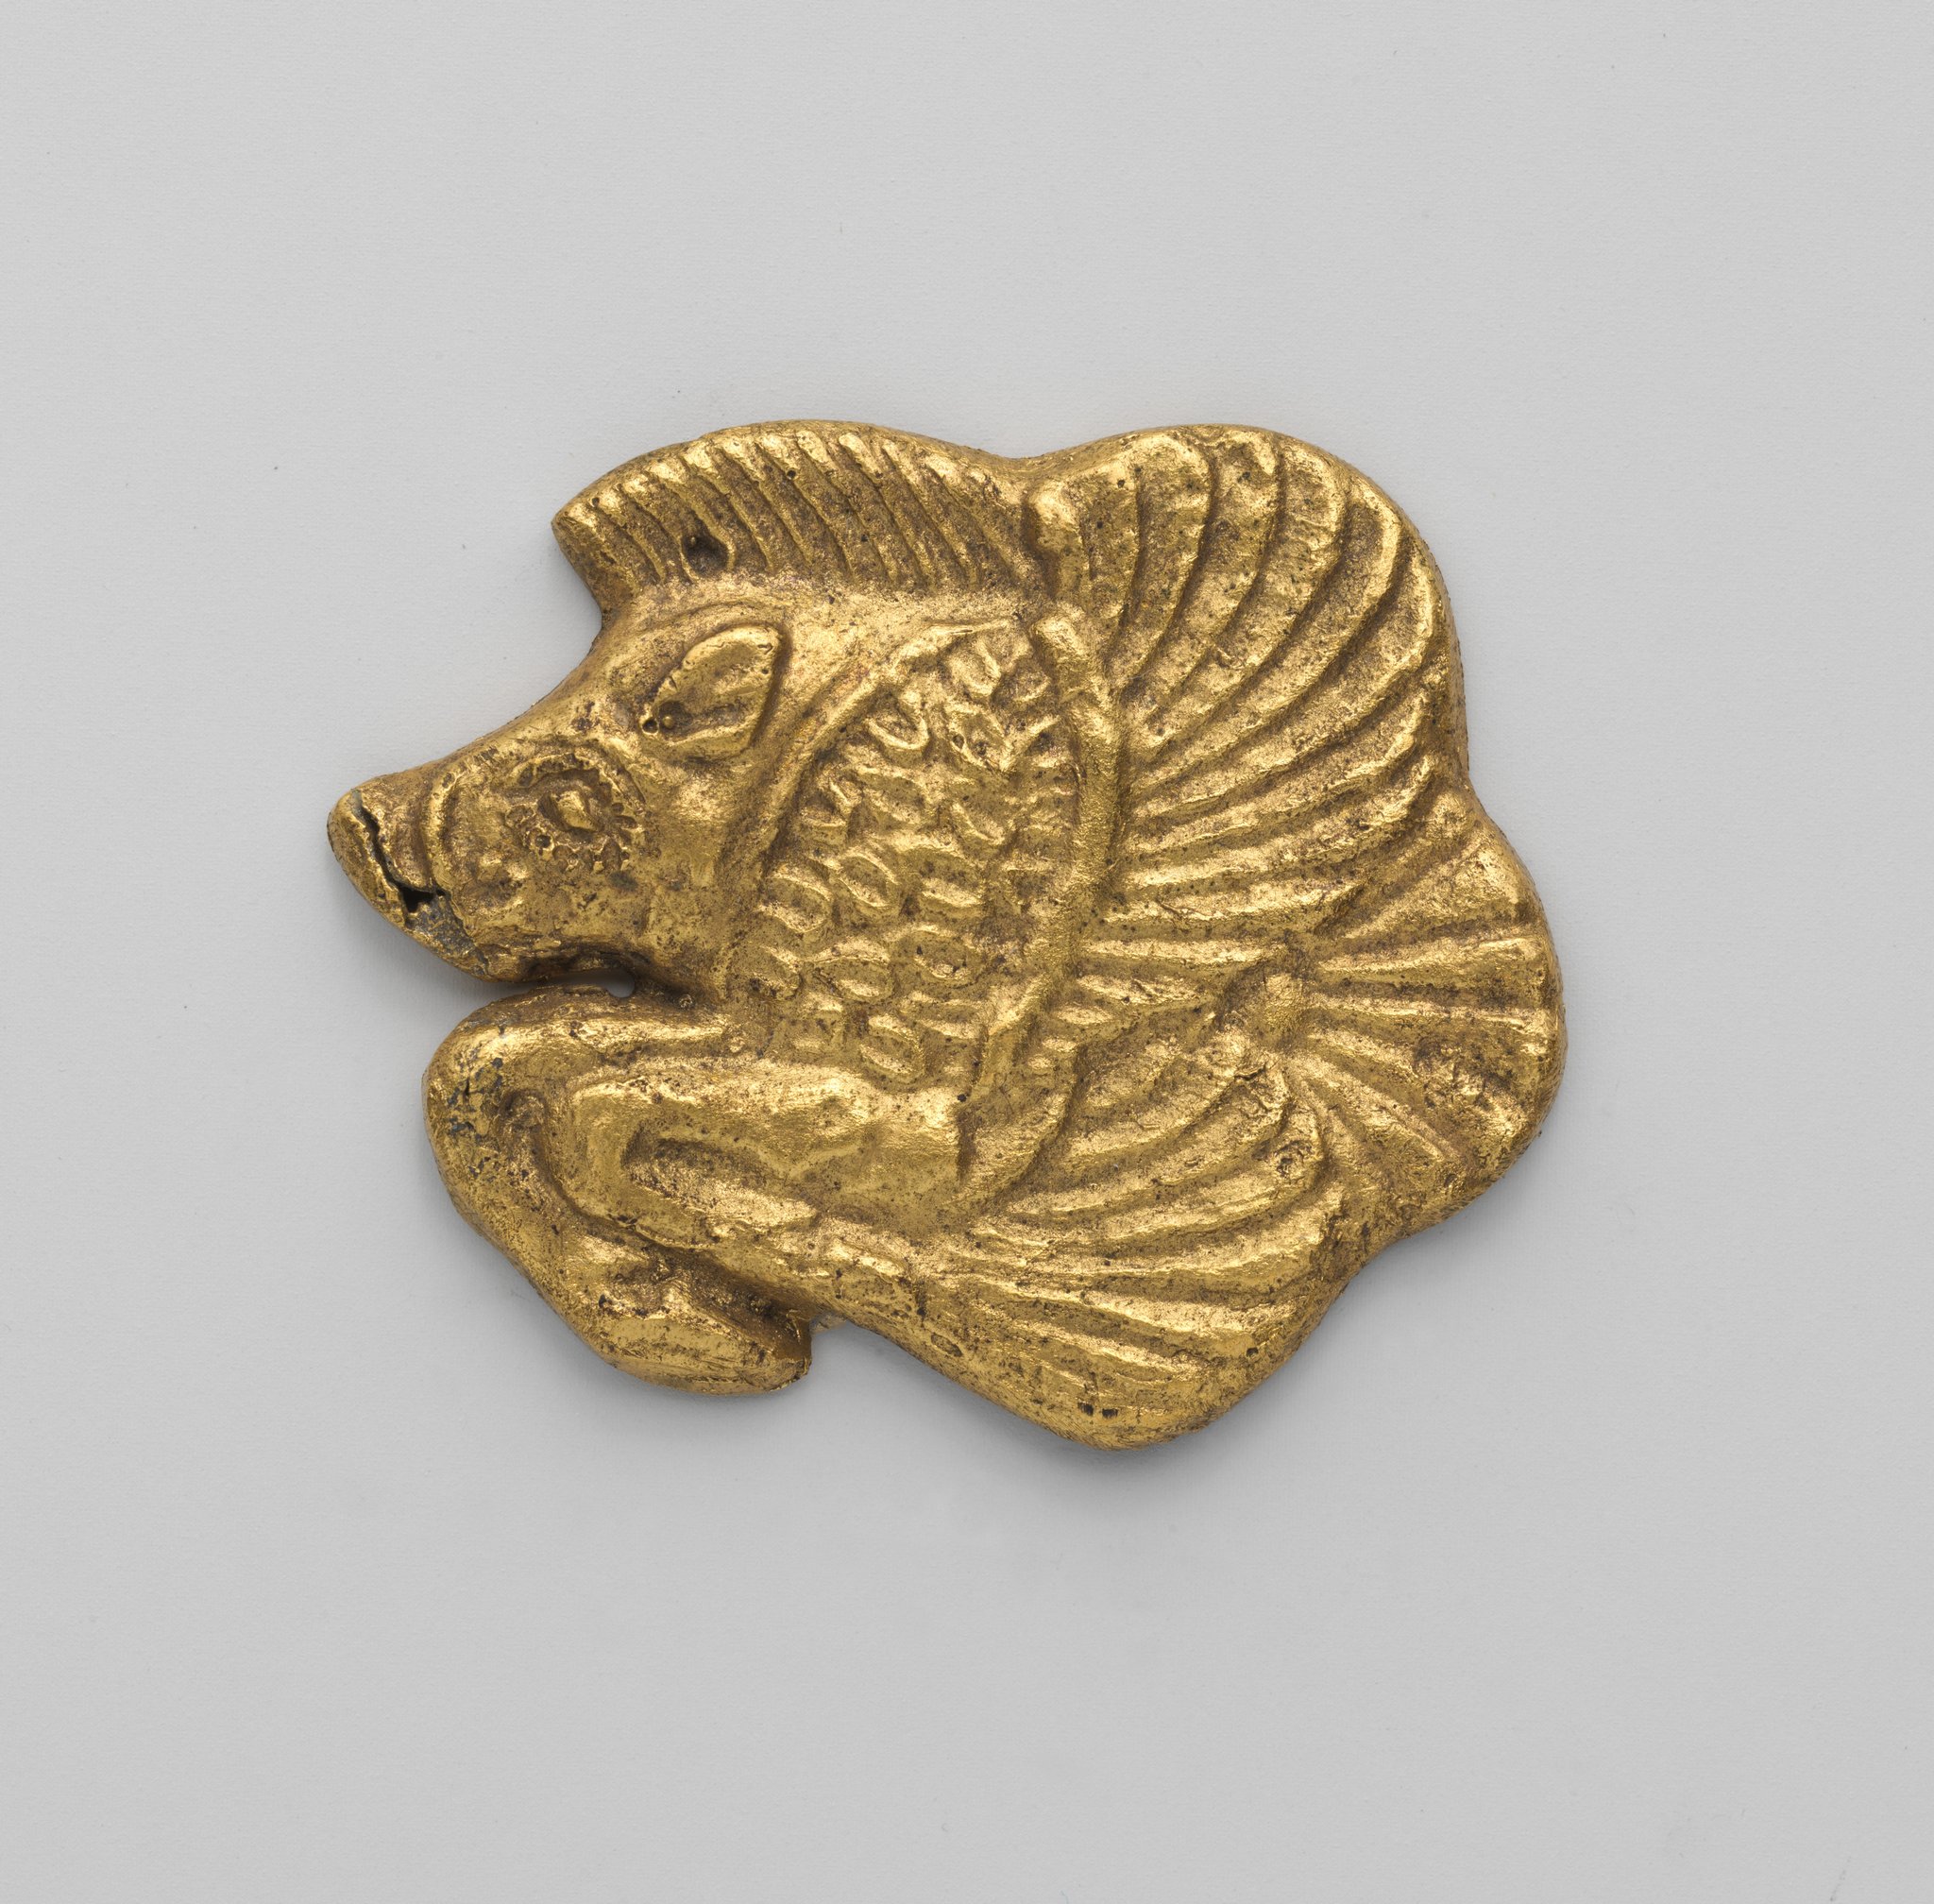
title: Reproduction of a Scythian plaque in the form of a winged boar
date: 1801-1900